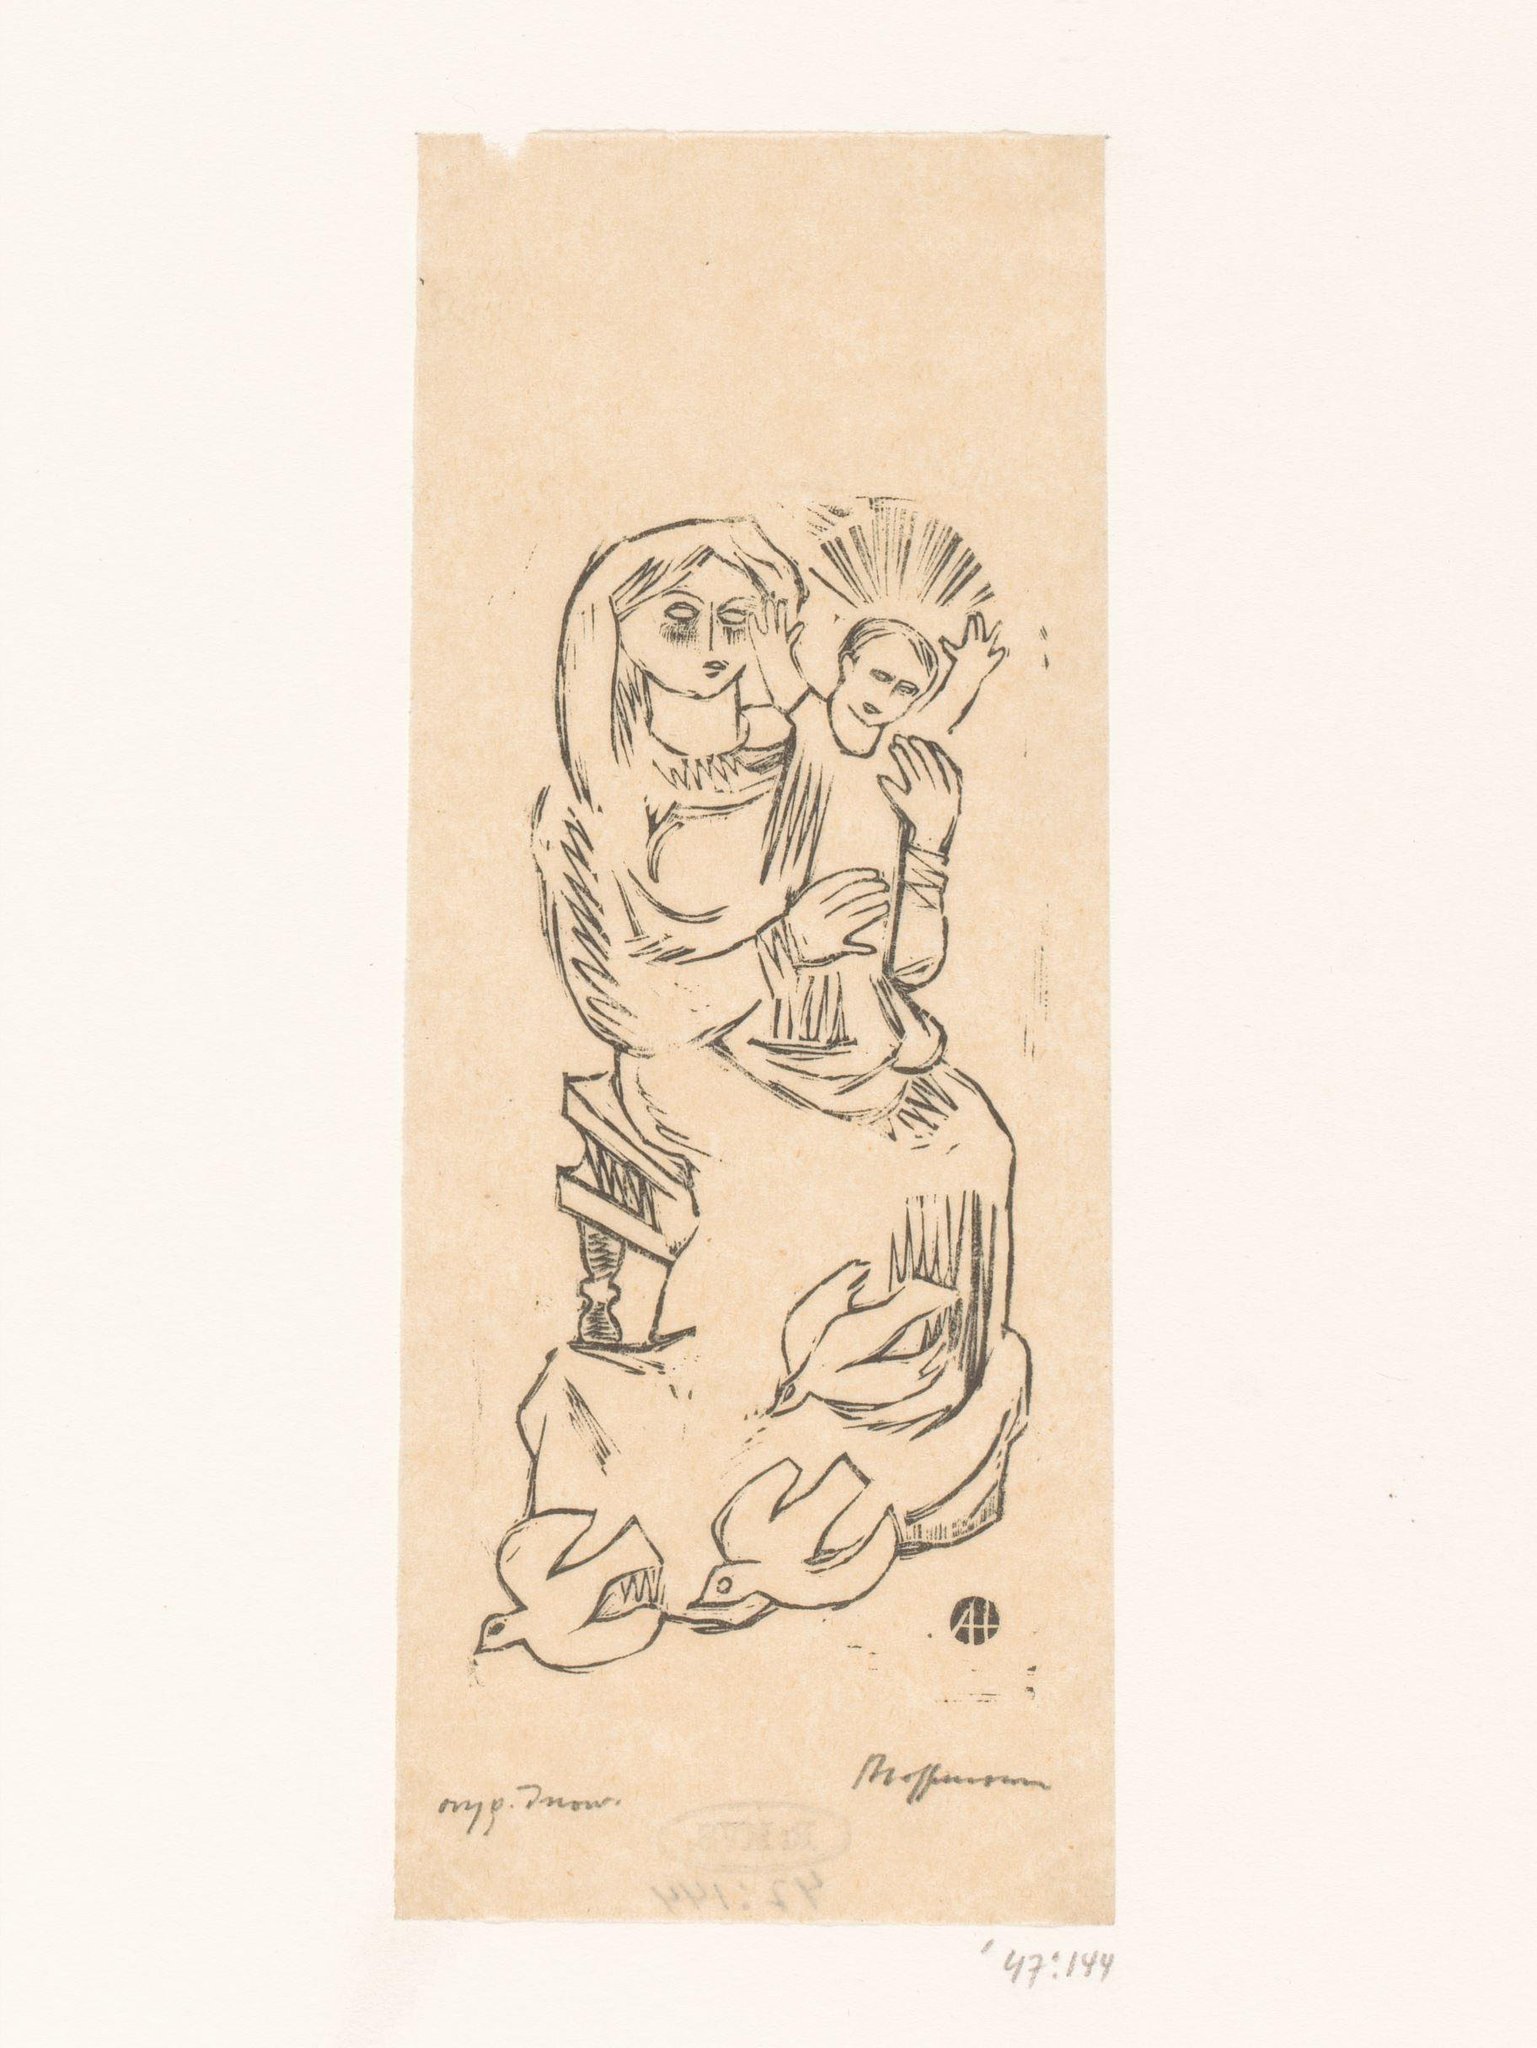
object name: print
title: Nowy Rok Bieży 1946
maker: ad. hoffmann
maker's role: print maker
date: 1946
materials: paper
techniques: woodcut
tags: boy (child between toddler and youth), horse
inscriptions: collector's mark: Lugt 2228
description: Geboorte- en sterfdatum van de prentmaker zijn onbekend. Daarom is voor de bepaling van de rechten van dit object gebruik gemaakt van de verwervingsdatum Rijksmuseum Amsterdam.